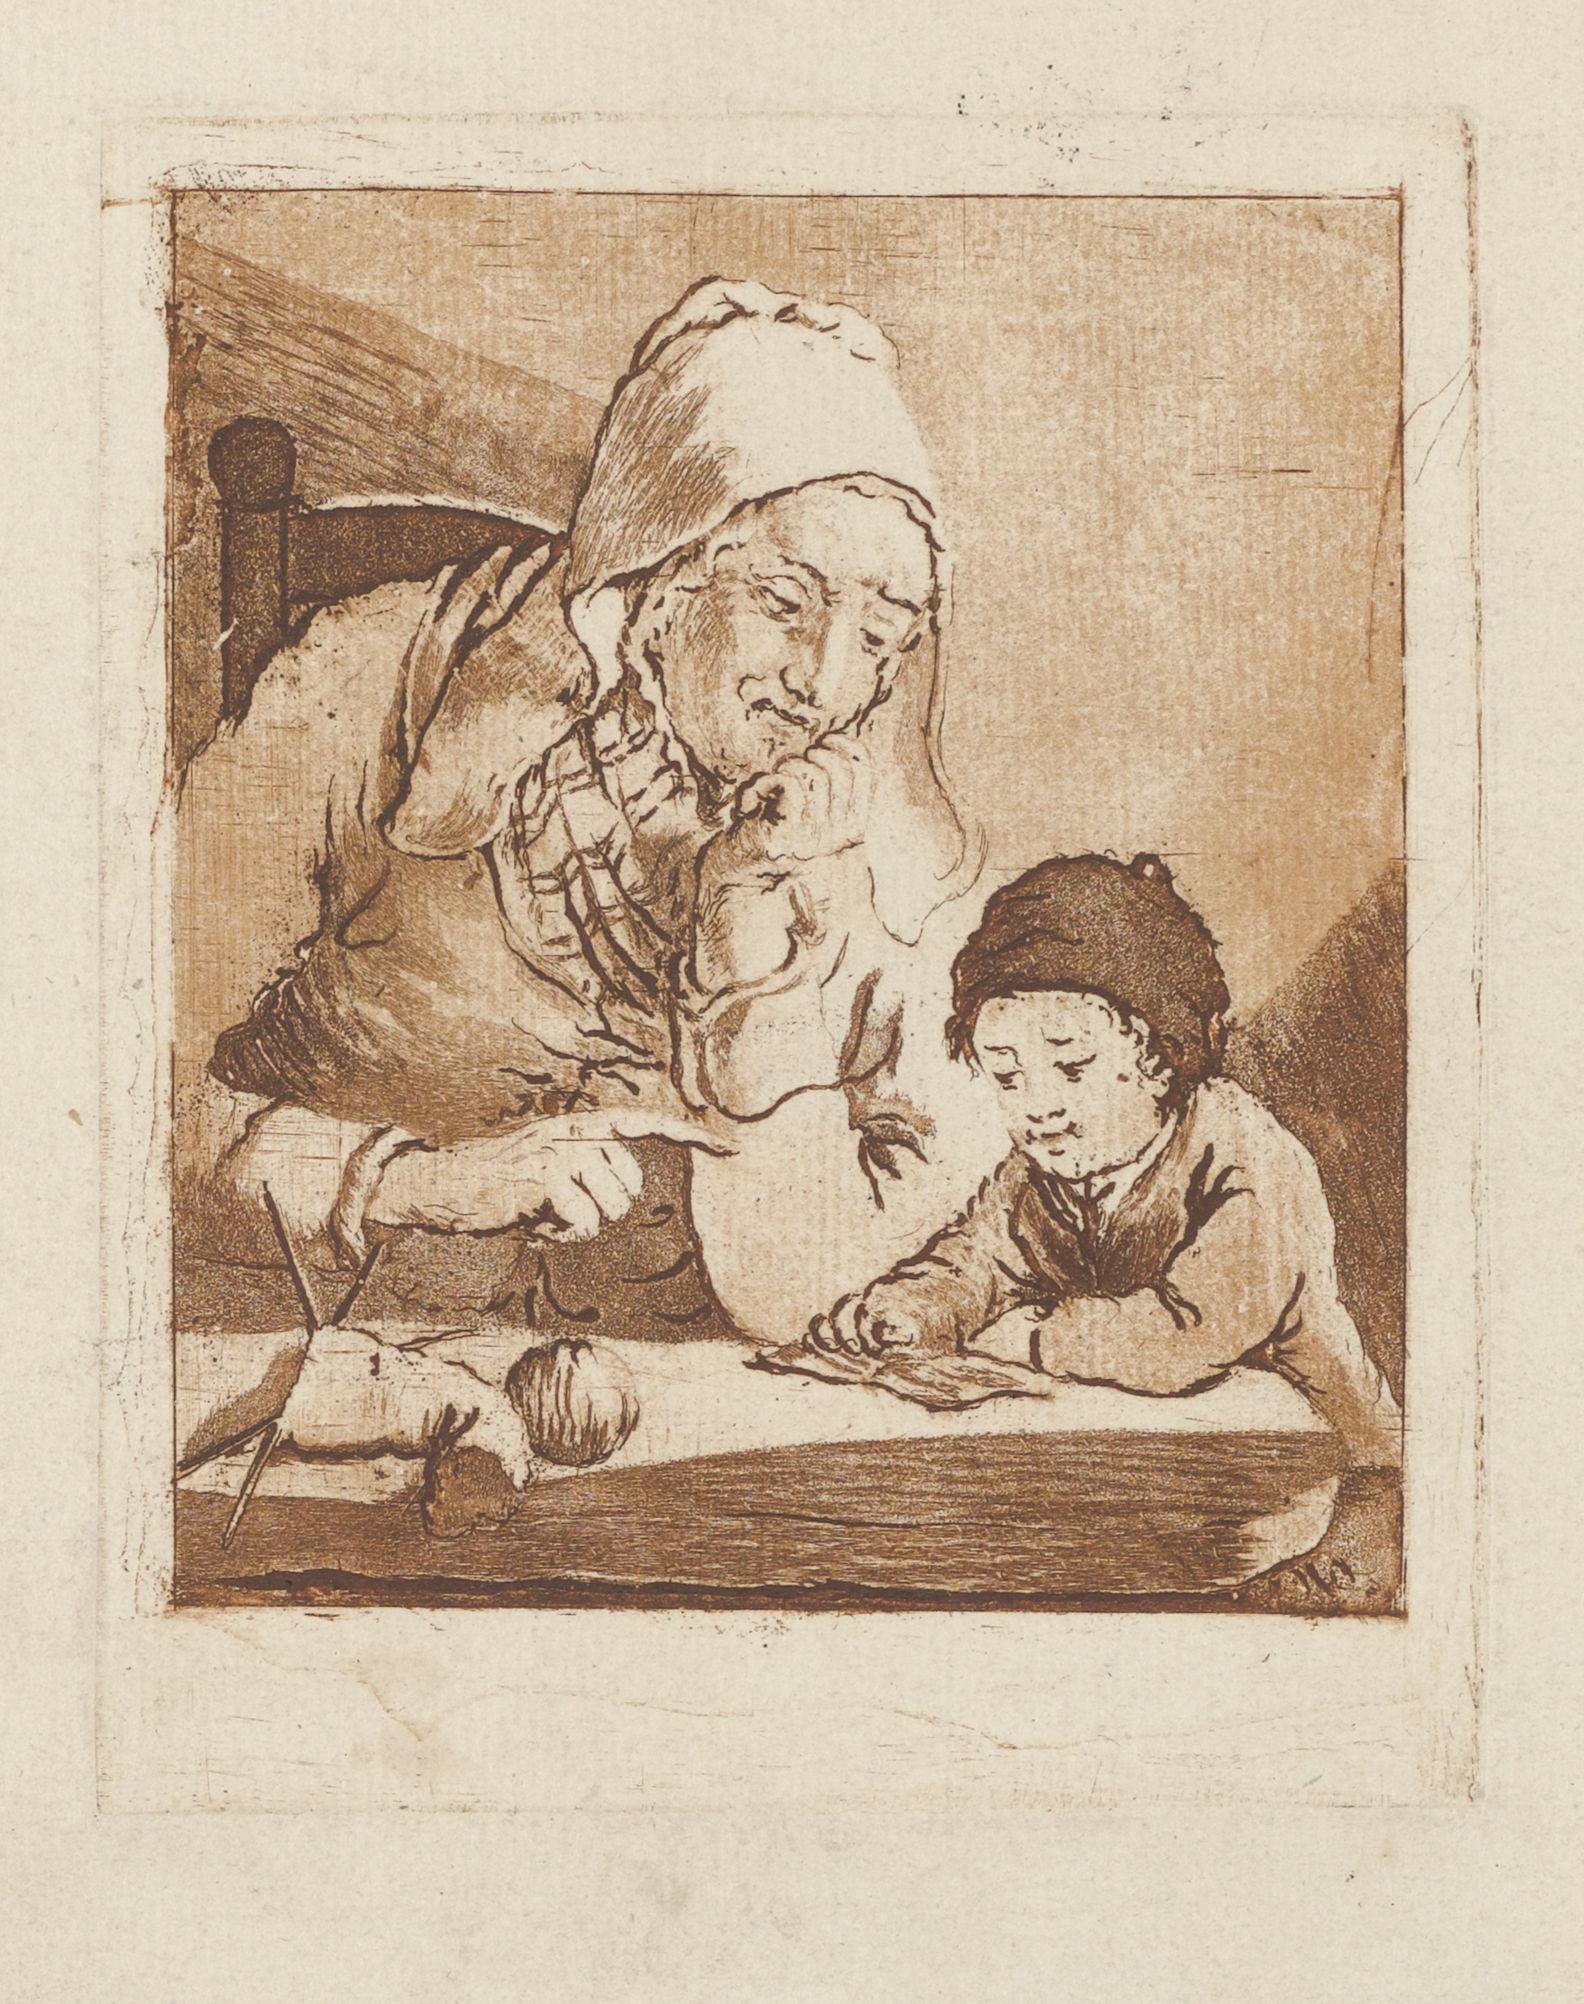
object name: print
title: Vrouw onderwijst een kind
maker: Anonymous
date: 1700-1900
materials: paper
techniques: aquatint, etching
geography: netherlands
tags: child (at home)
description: Een vrouw onderwijst een kind. Op tafel ligt een breiwerk.